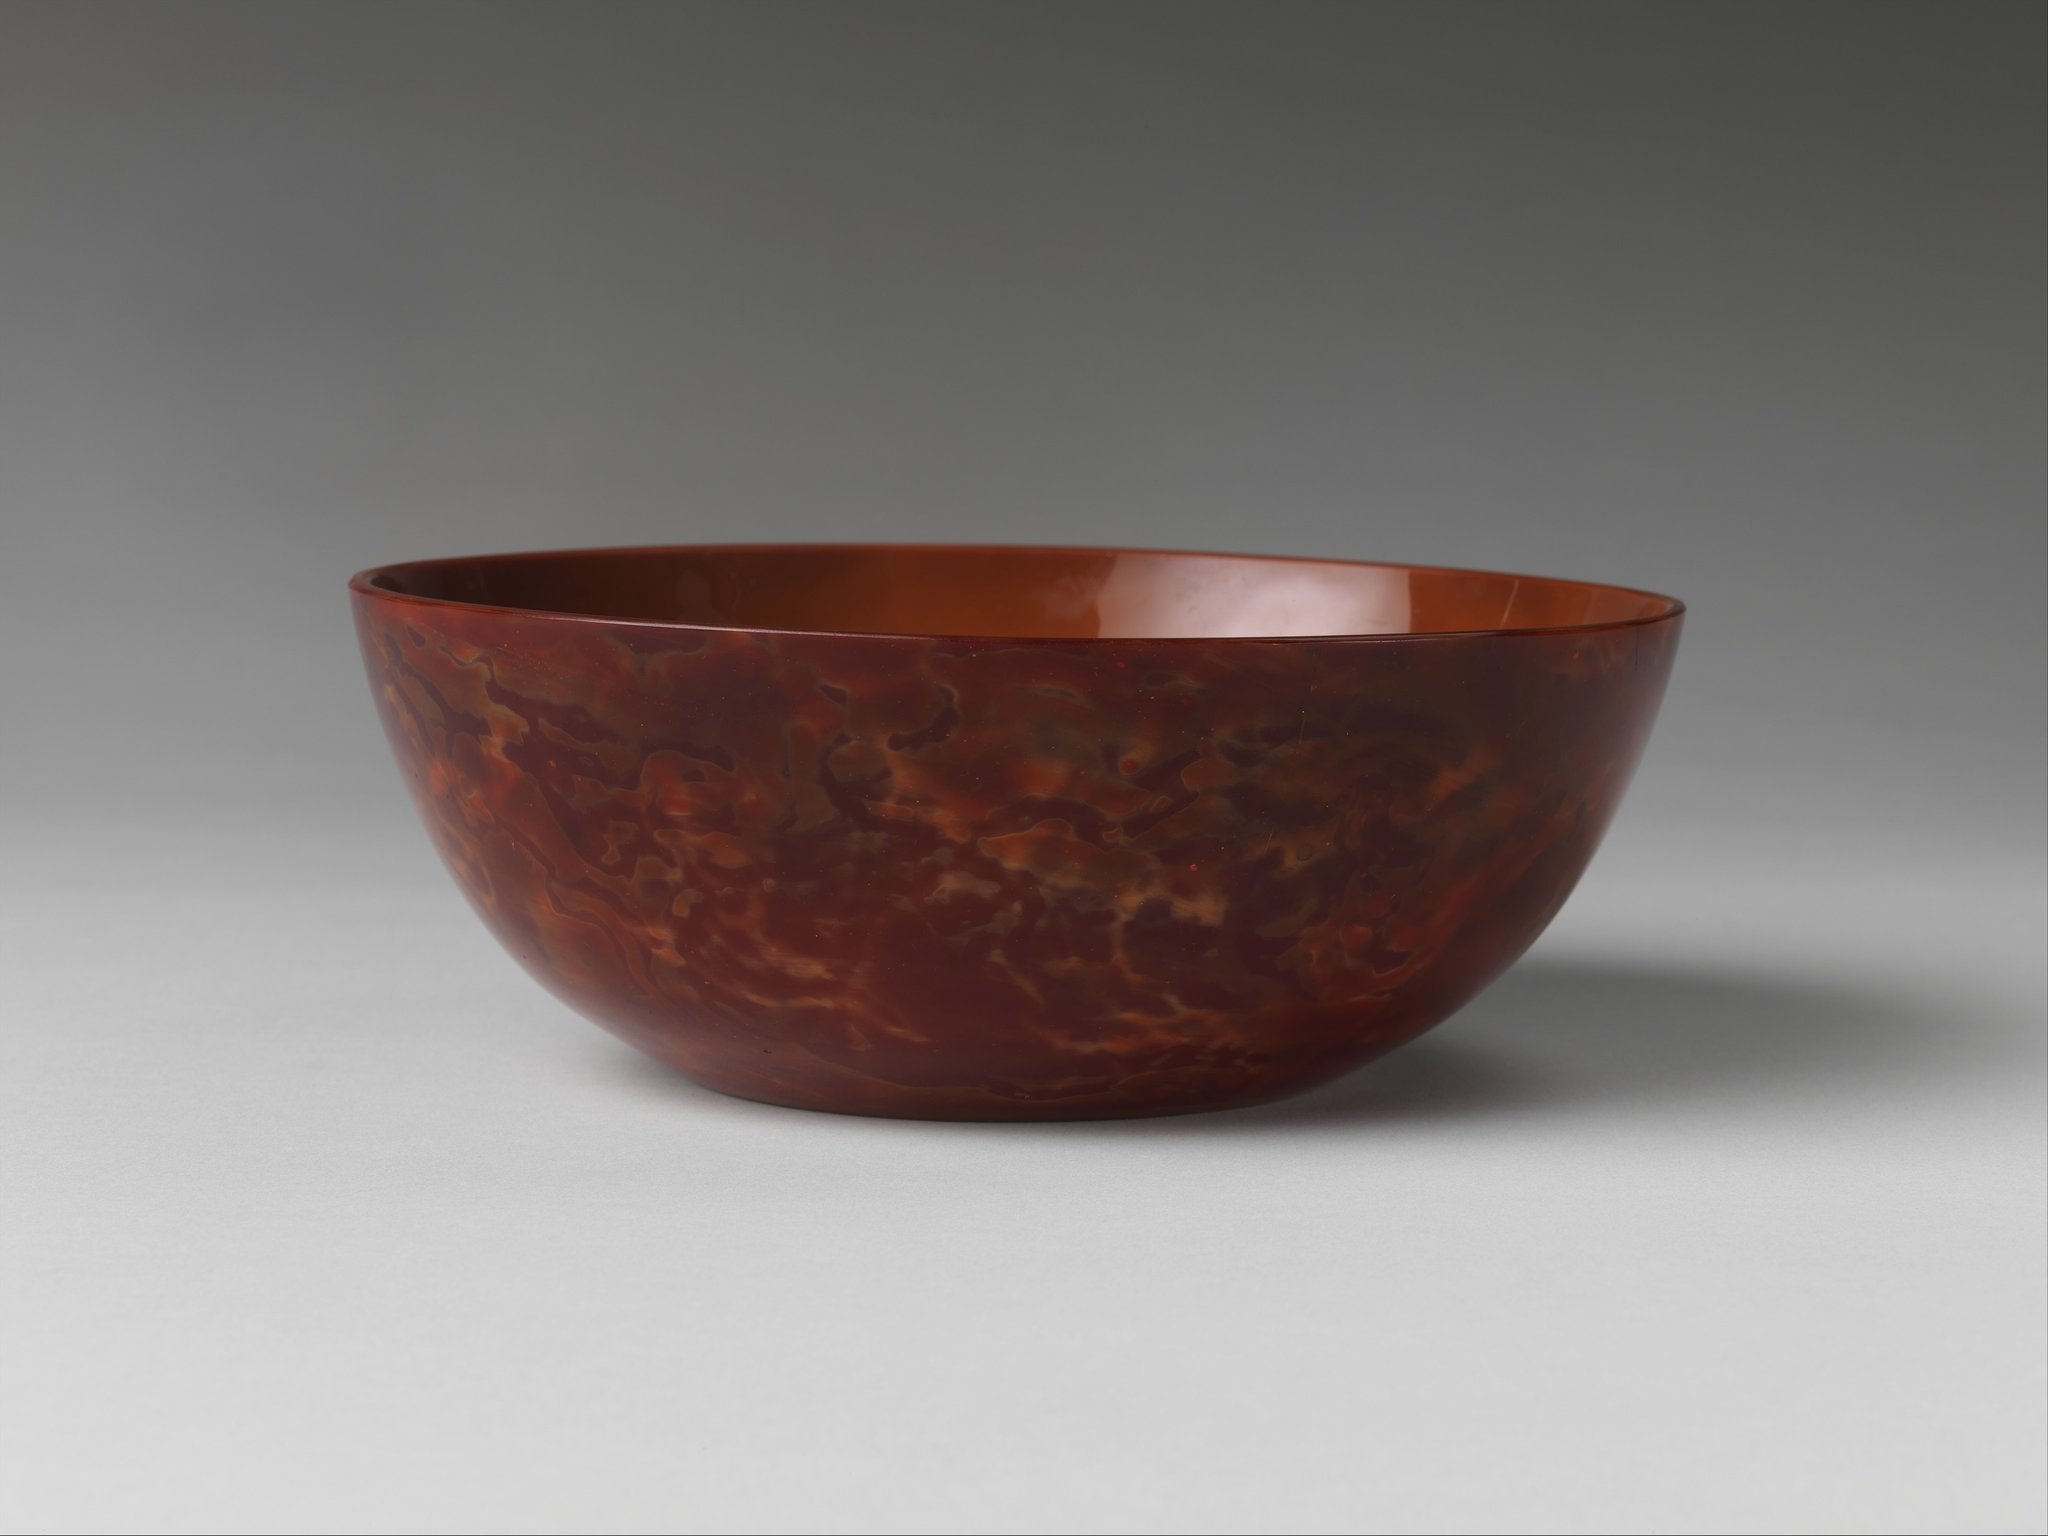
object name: bowl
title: Bowl imitating realgar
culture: chinese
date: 1767-1833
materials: glass